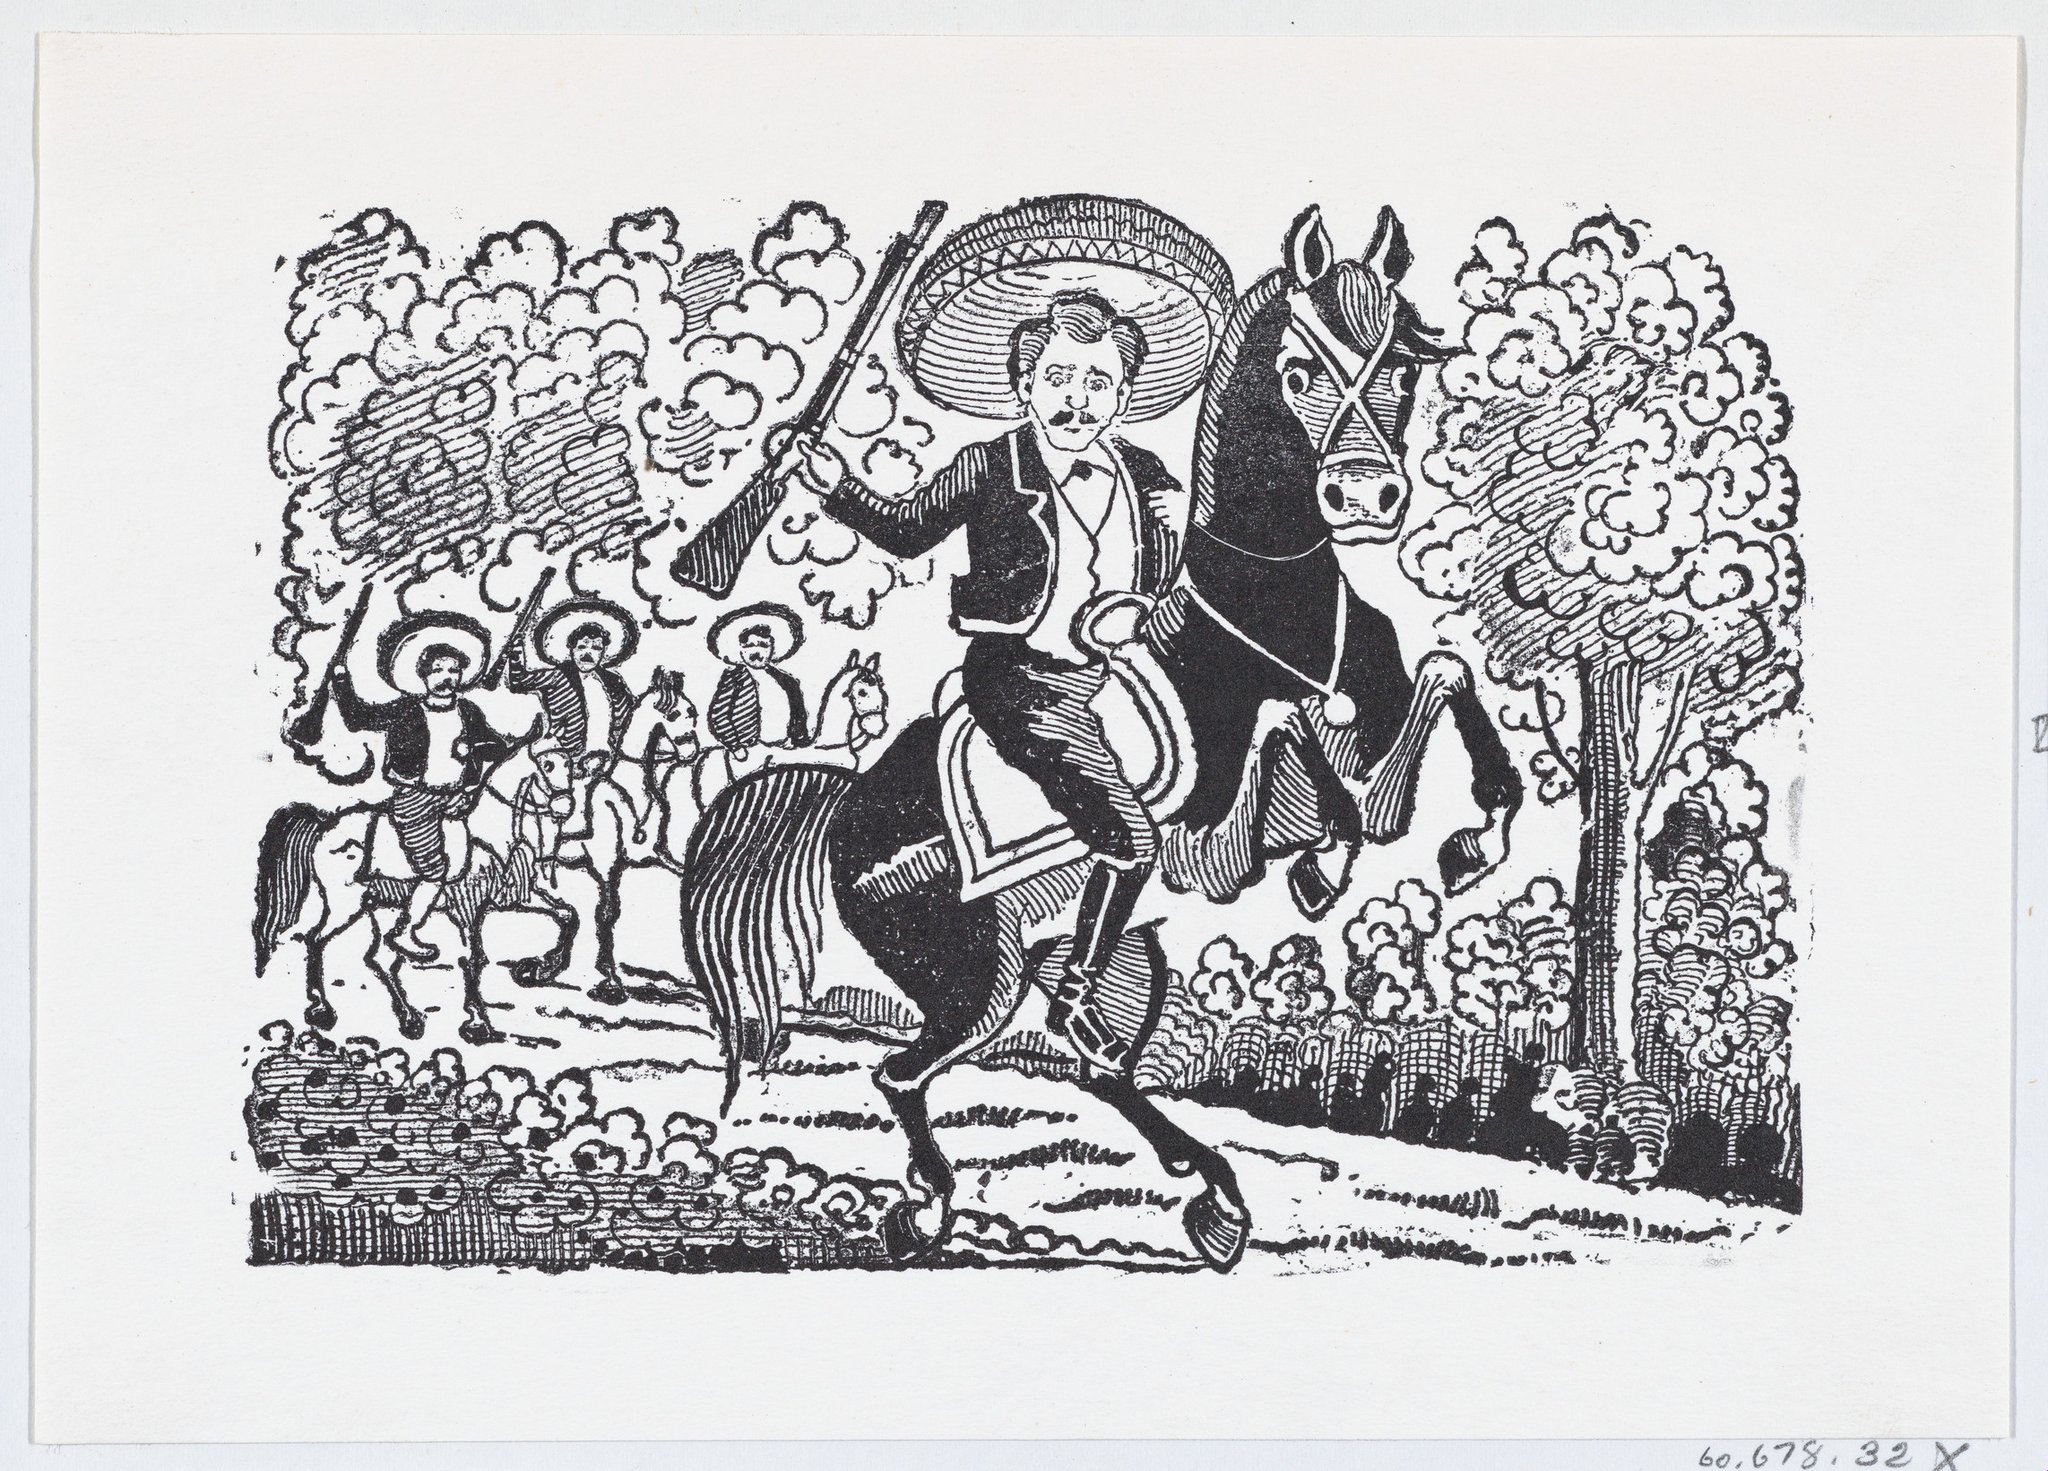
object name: print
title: A revolutionary soldier on horseback with a rifle (Heraclio Bernal)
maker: josé guadalupe posada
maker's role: artist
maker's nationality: mexican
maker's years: 1852-1913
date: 1911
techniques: lithography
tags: firearms,men,horses